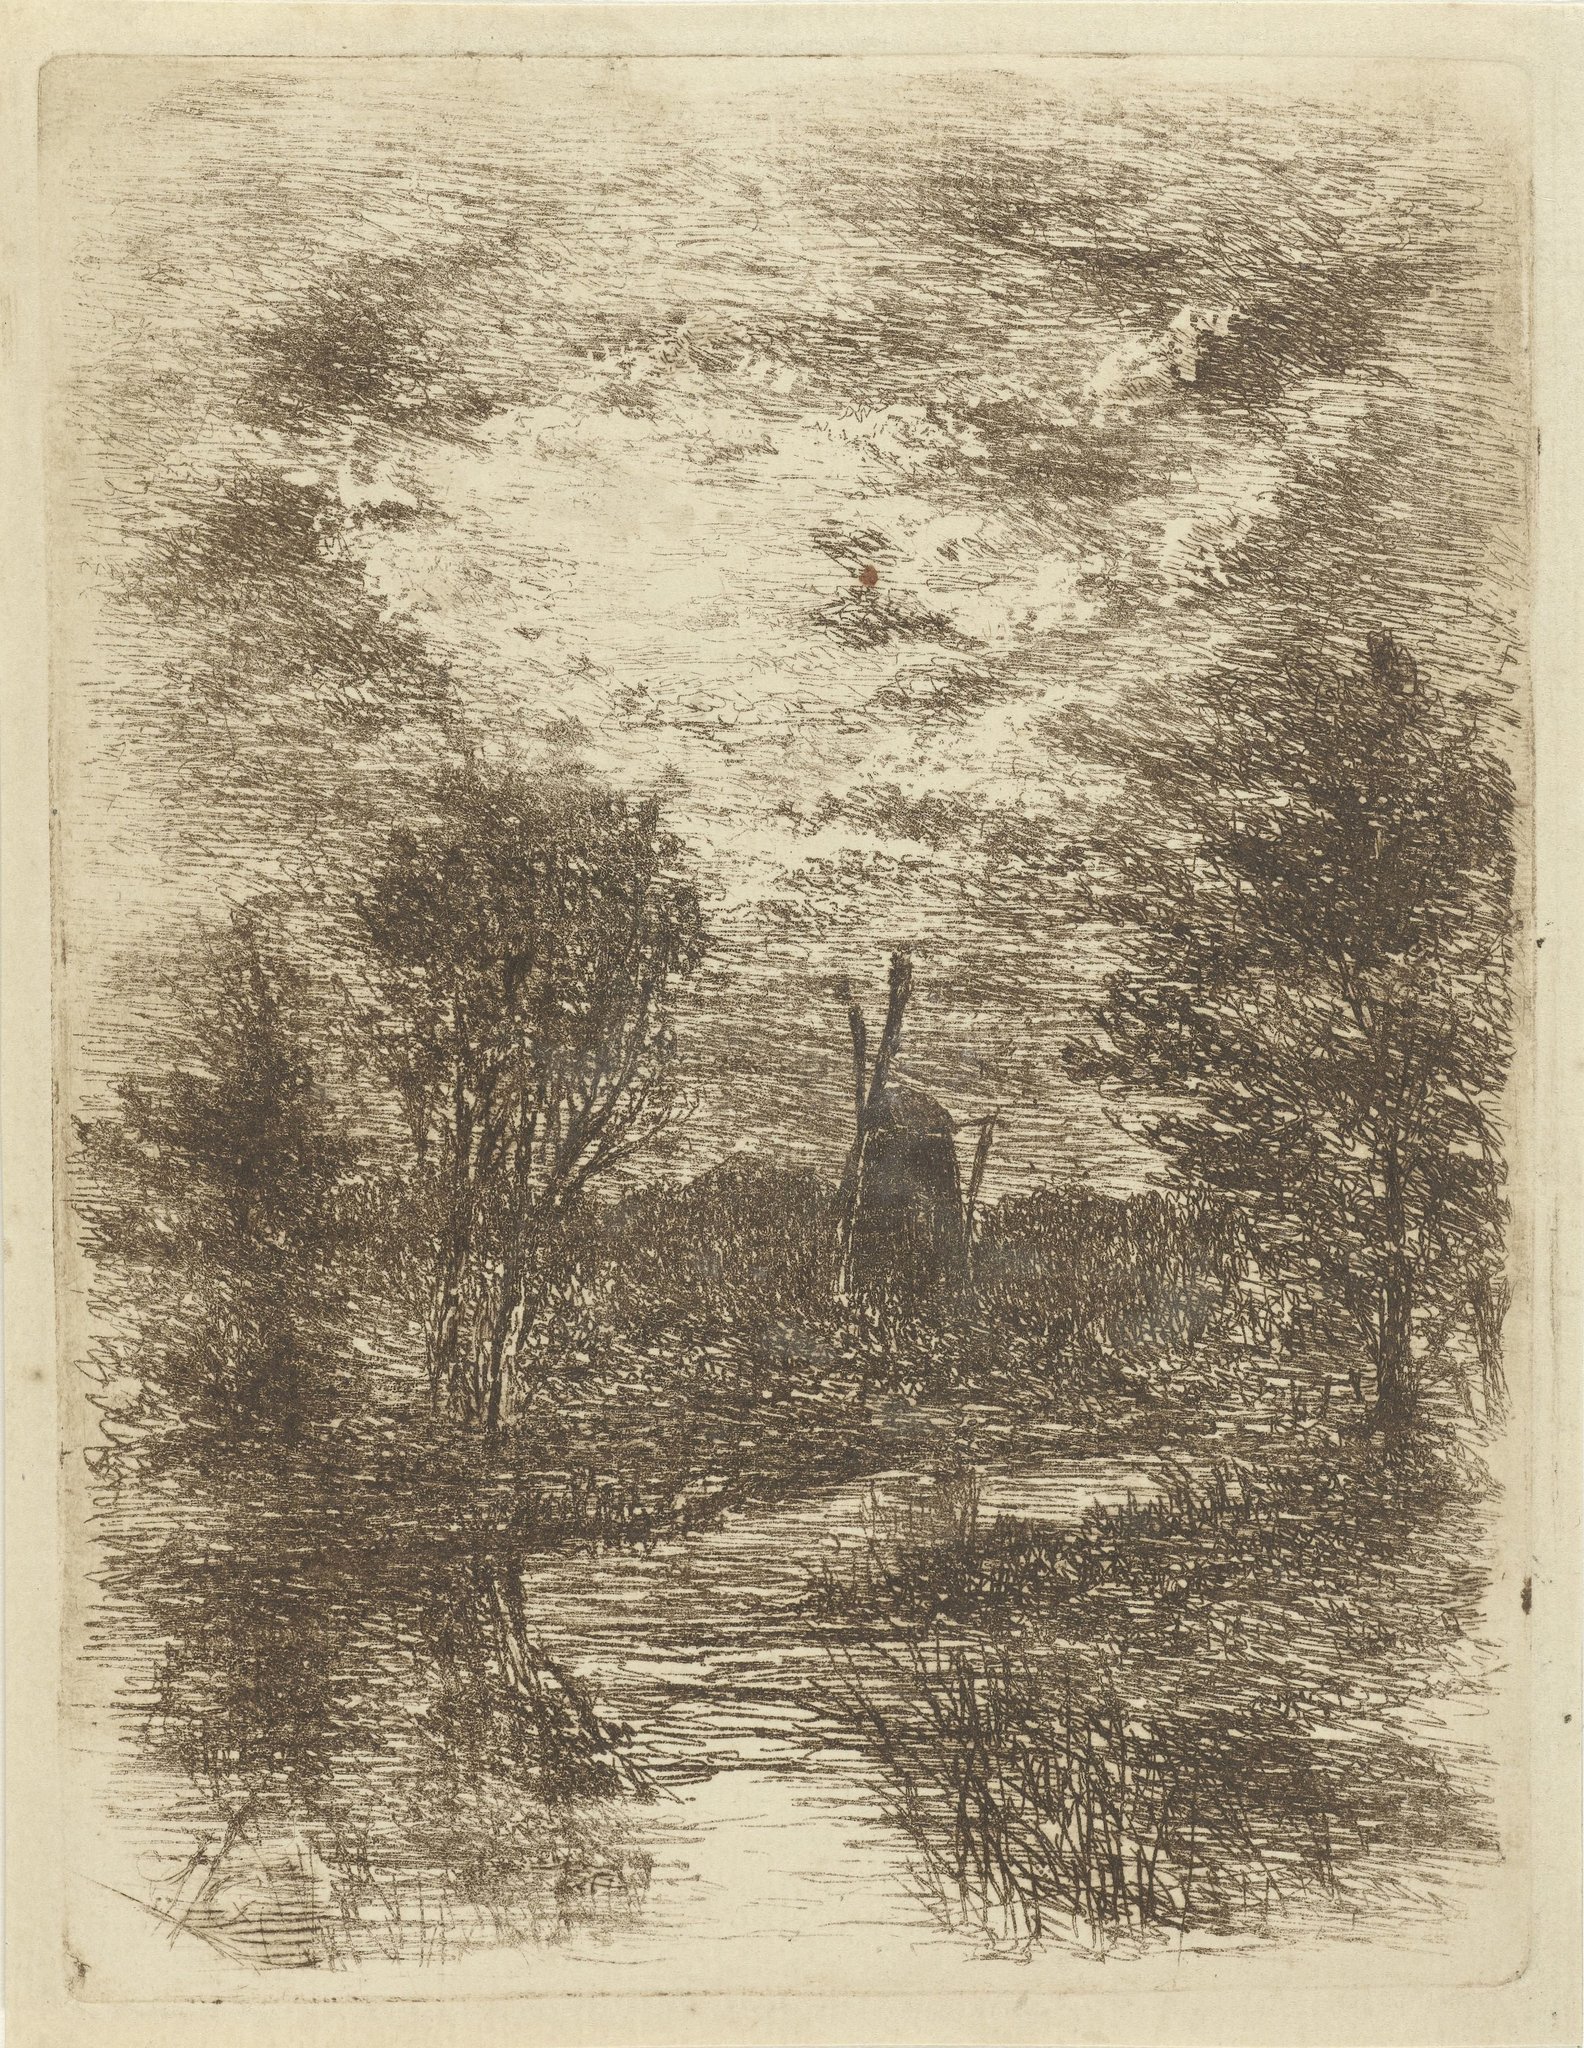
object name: print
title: Landschap met molen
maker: johan frederik croockewit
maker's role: print maker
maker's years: 1832-1898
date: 1842-1898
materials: paper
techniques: drypoint, etching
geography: amsterdam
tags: windmill in landscape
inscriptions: collector's mark: Lugt 2228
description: Landschap met molen. Op de voorgrond een beekje.